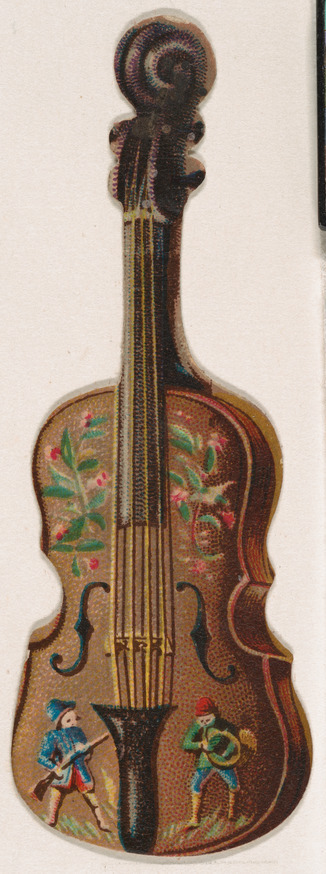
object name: print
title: Violin, from the Novelties series (N228, Type 3) issued by Kinney Bros.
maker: kinney brothers tobacco company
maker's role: publisher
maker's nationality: american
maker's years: 1869-2011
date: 1889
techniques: color lithograph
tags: men,violins,flowers,leaves